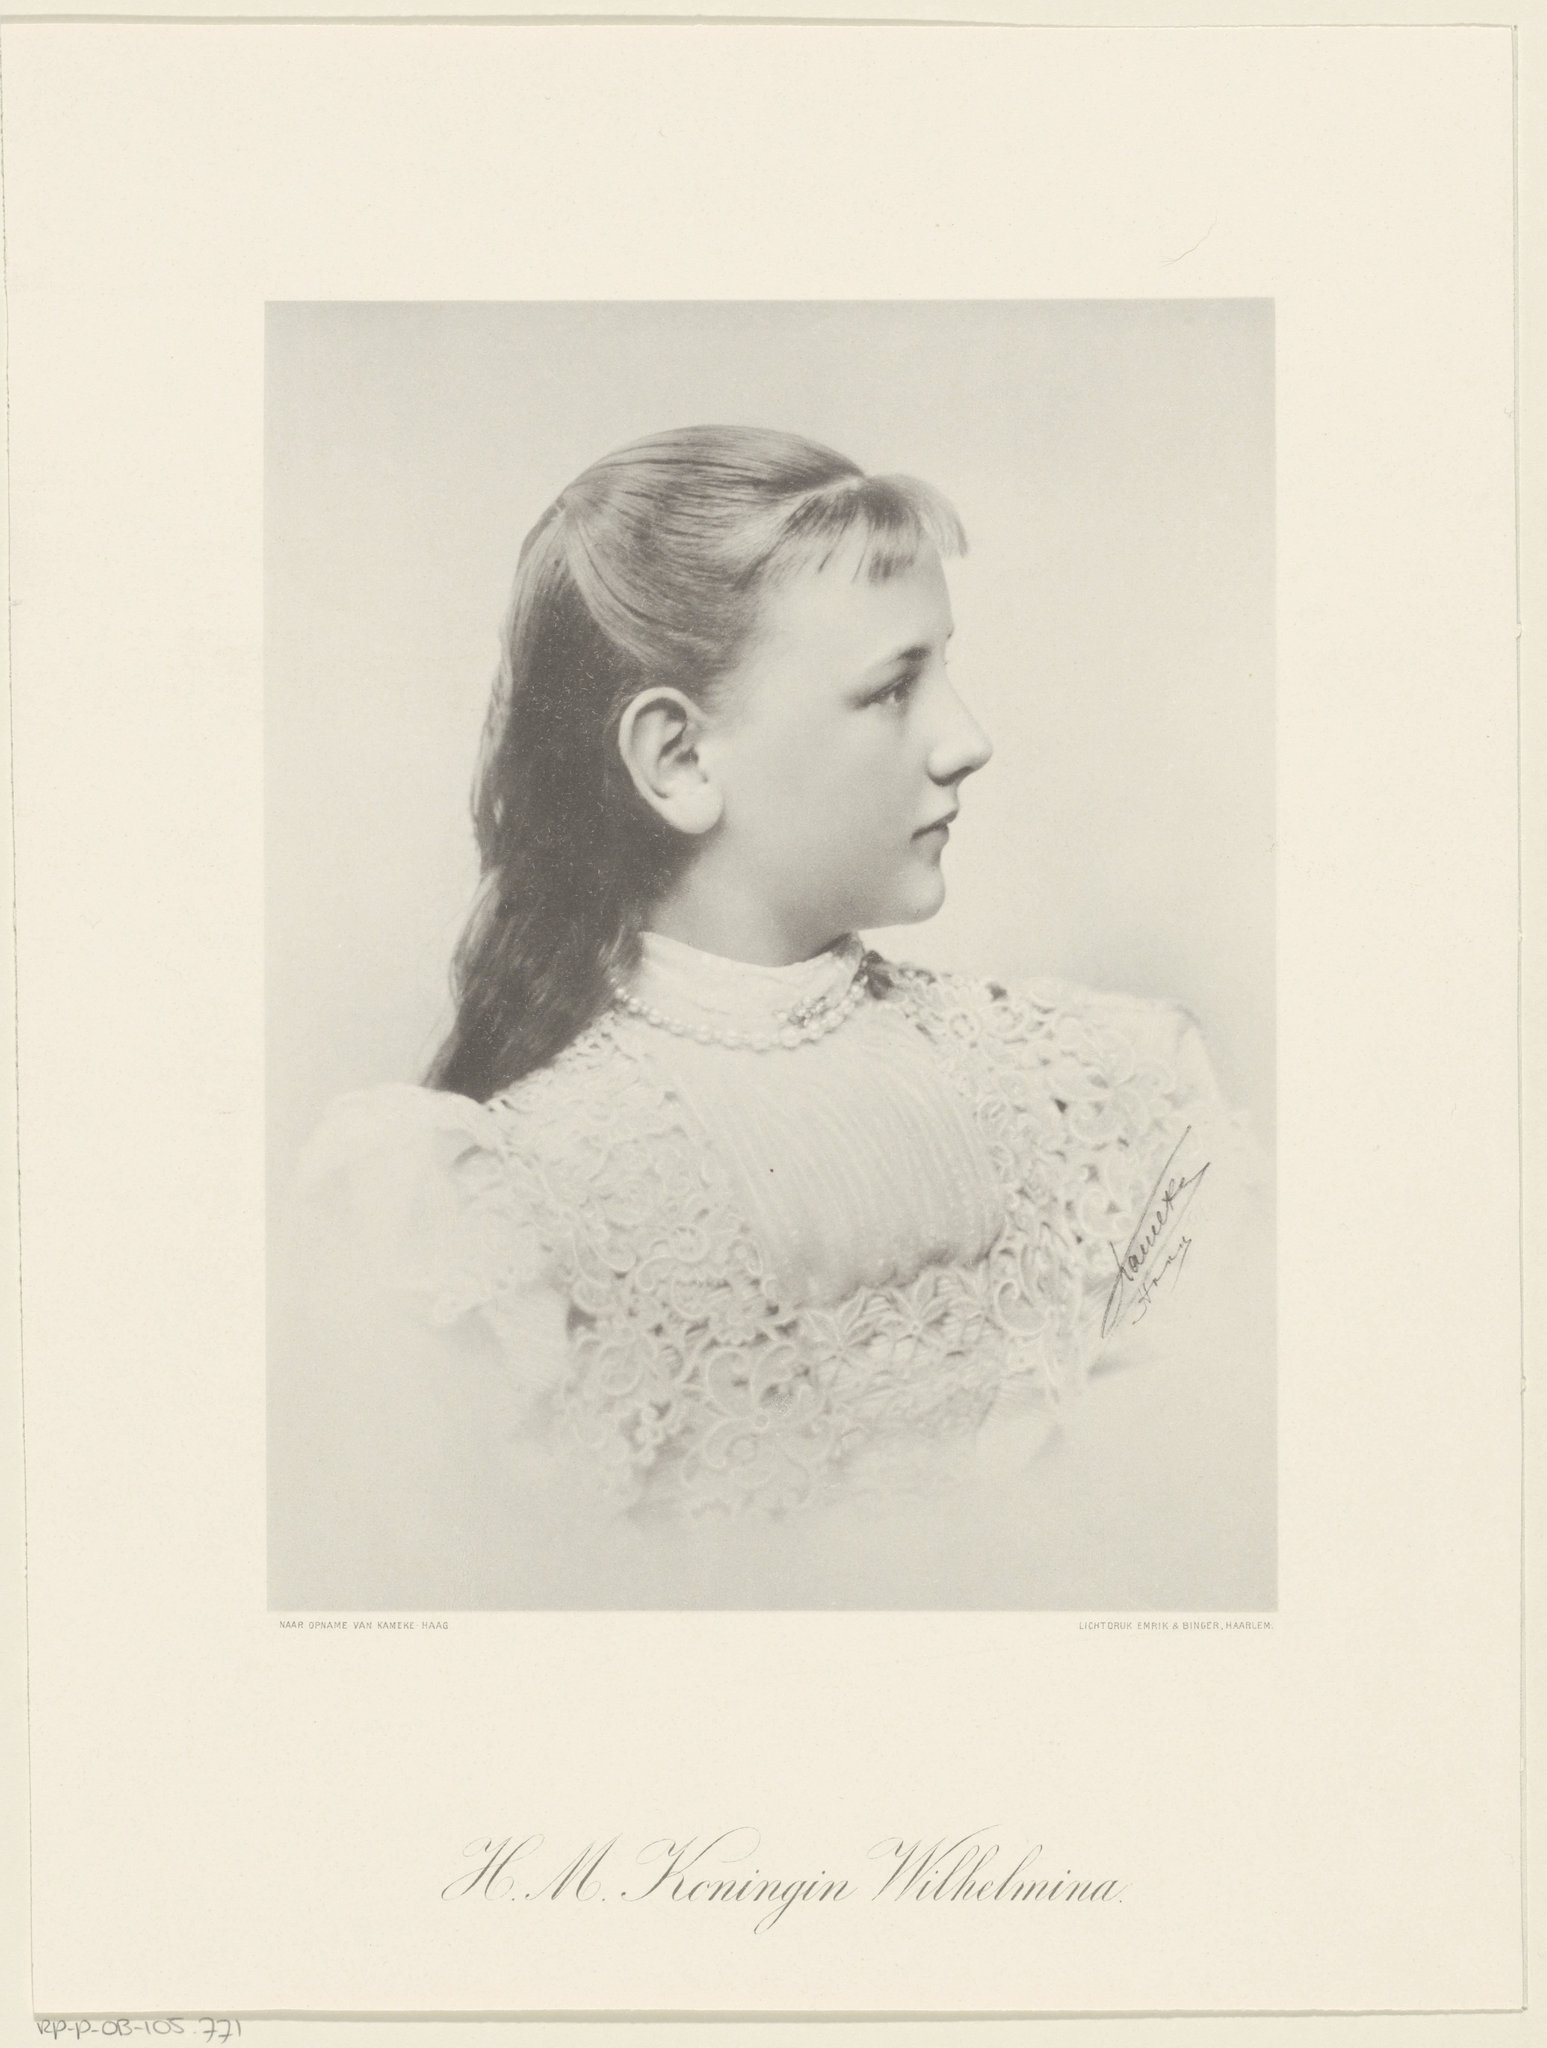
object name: photomechanical print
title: Portret van Wilhelmina, koningin der Nederlanden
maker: richard kameke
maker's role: fotograaf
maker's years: 1847-1898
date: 1890-1895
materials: paper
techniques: photograph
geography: haarlem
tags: the hague, print maker, wilhelmina of the netherlands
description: De hier vermelde titel verwijst naar de hoogst verkregen titel van de geportretteerde, niet per se naar de titel die de geportretteerde op deze voorstelling draagt.